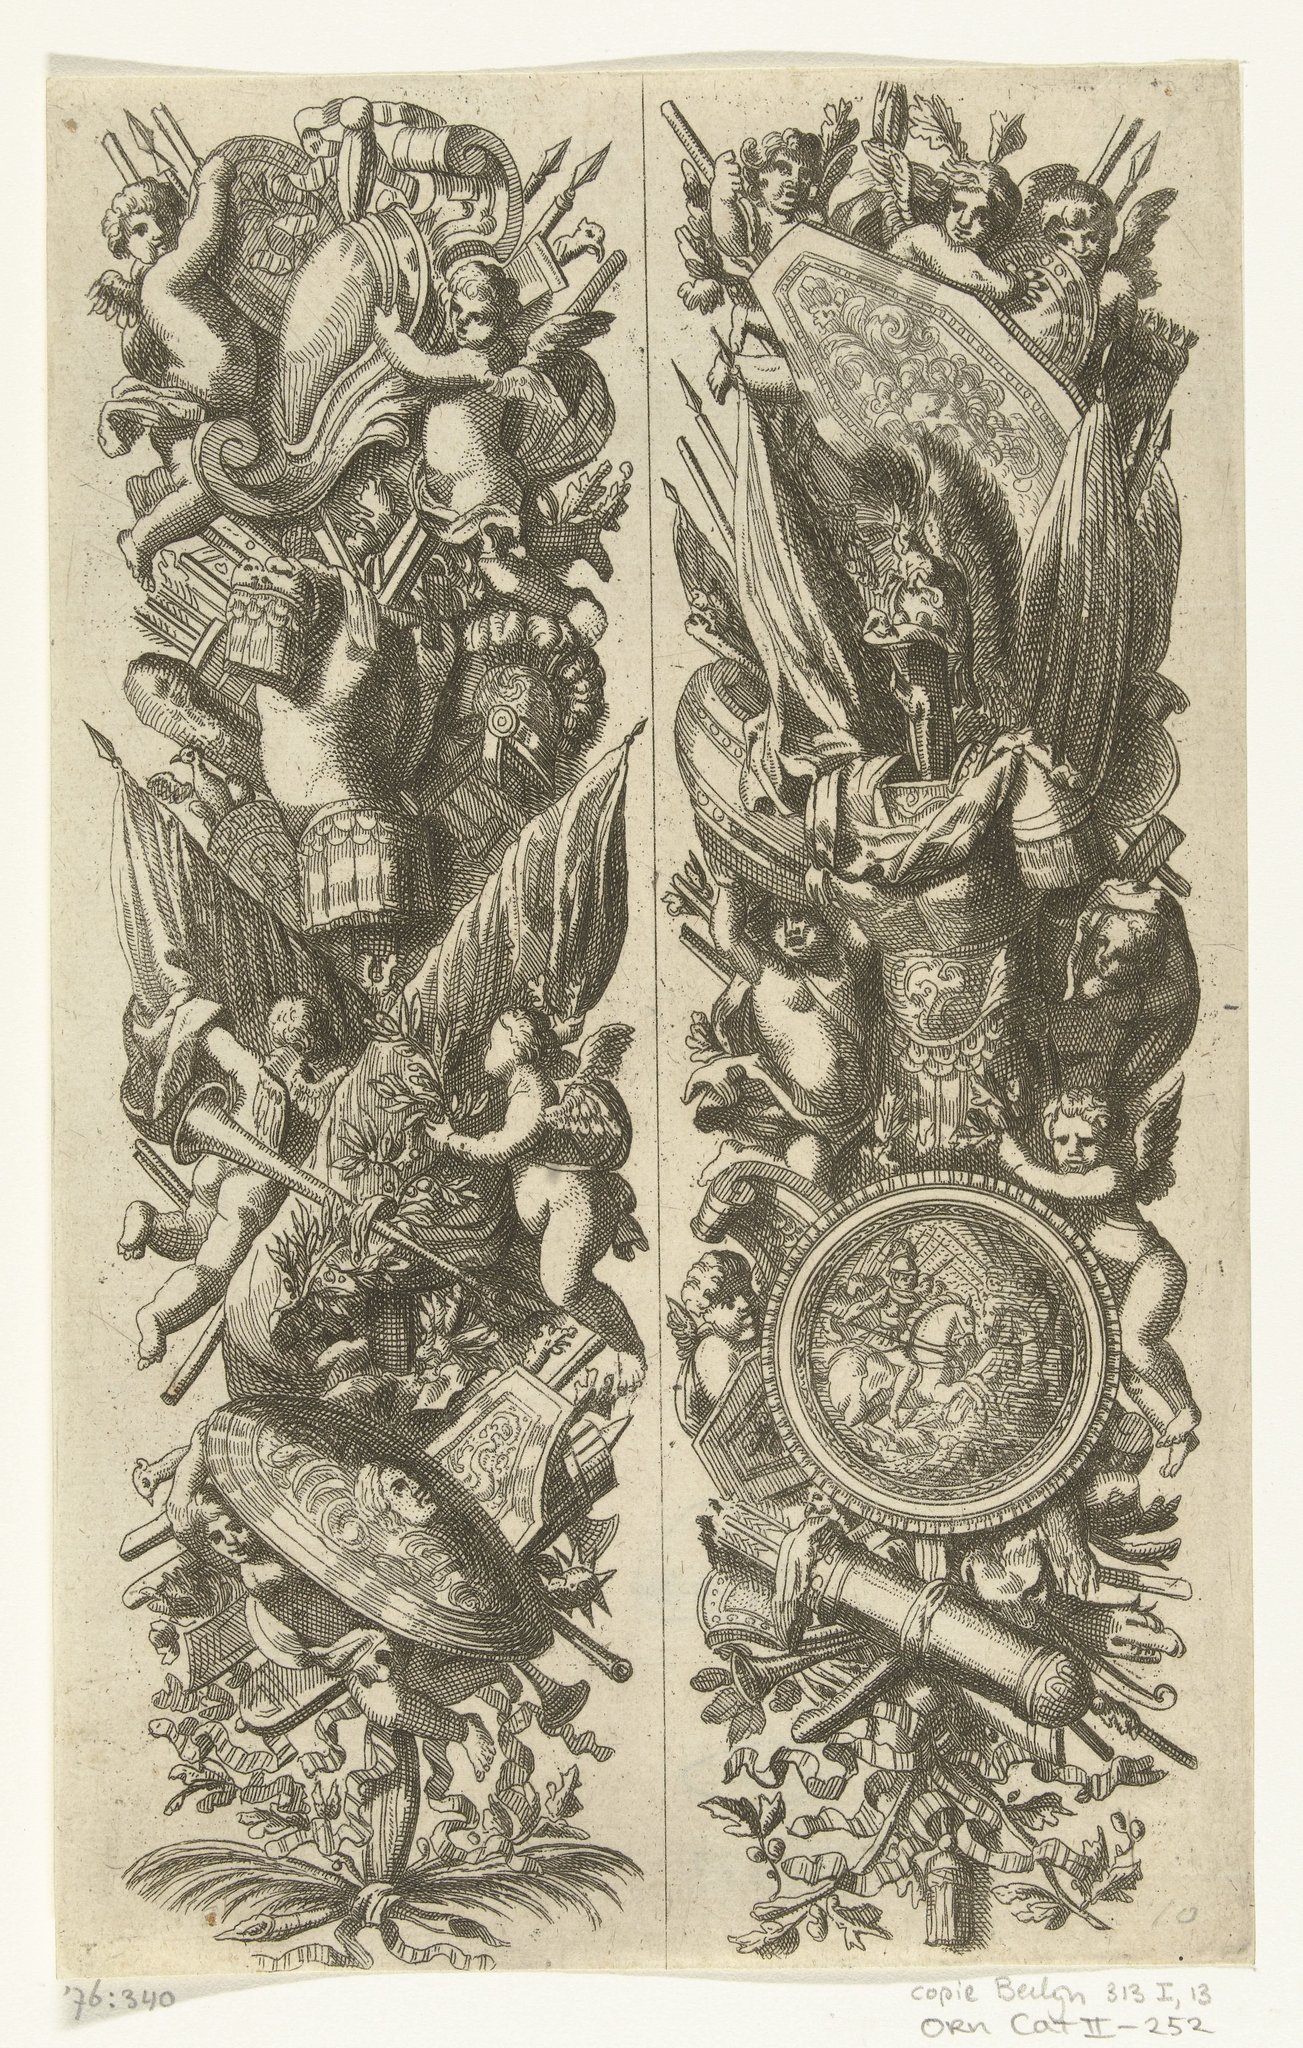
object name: print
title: Twee wapentrofeeën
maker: Anonymous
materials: paper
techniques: etching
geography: netherlands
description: Wapentrofeeën bevestigd aan linten met palm- en eikentakken.